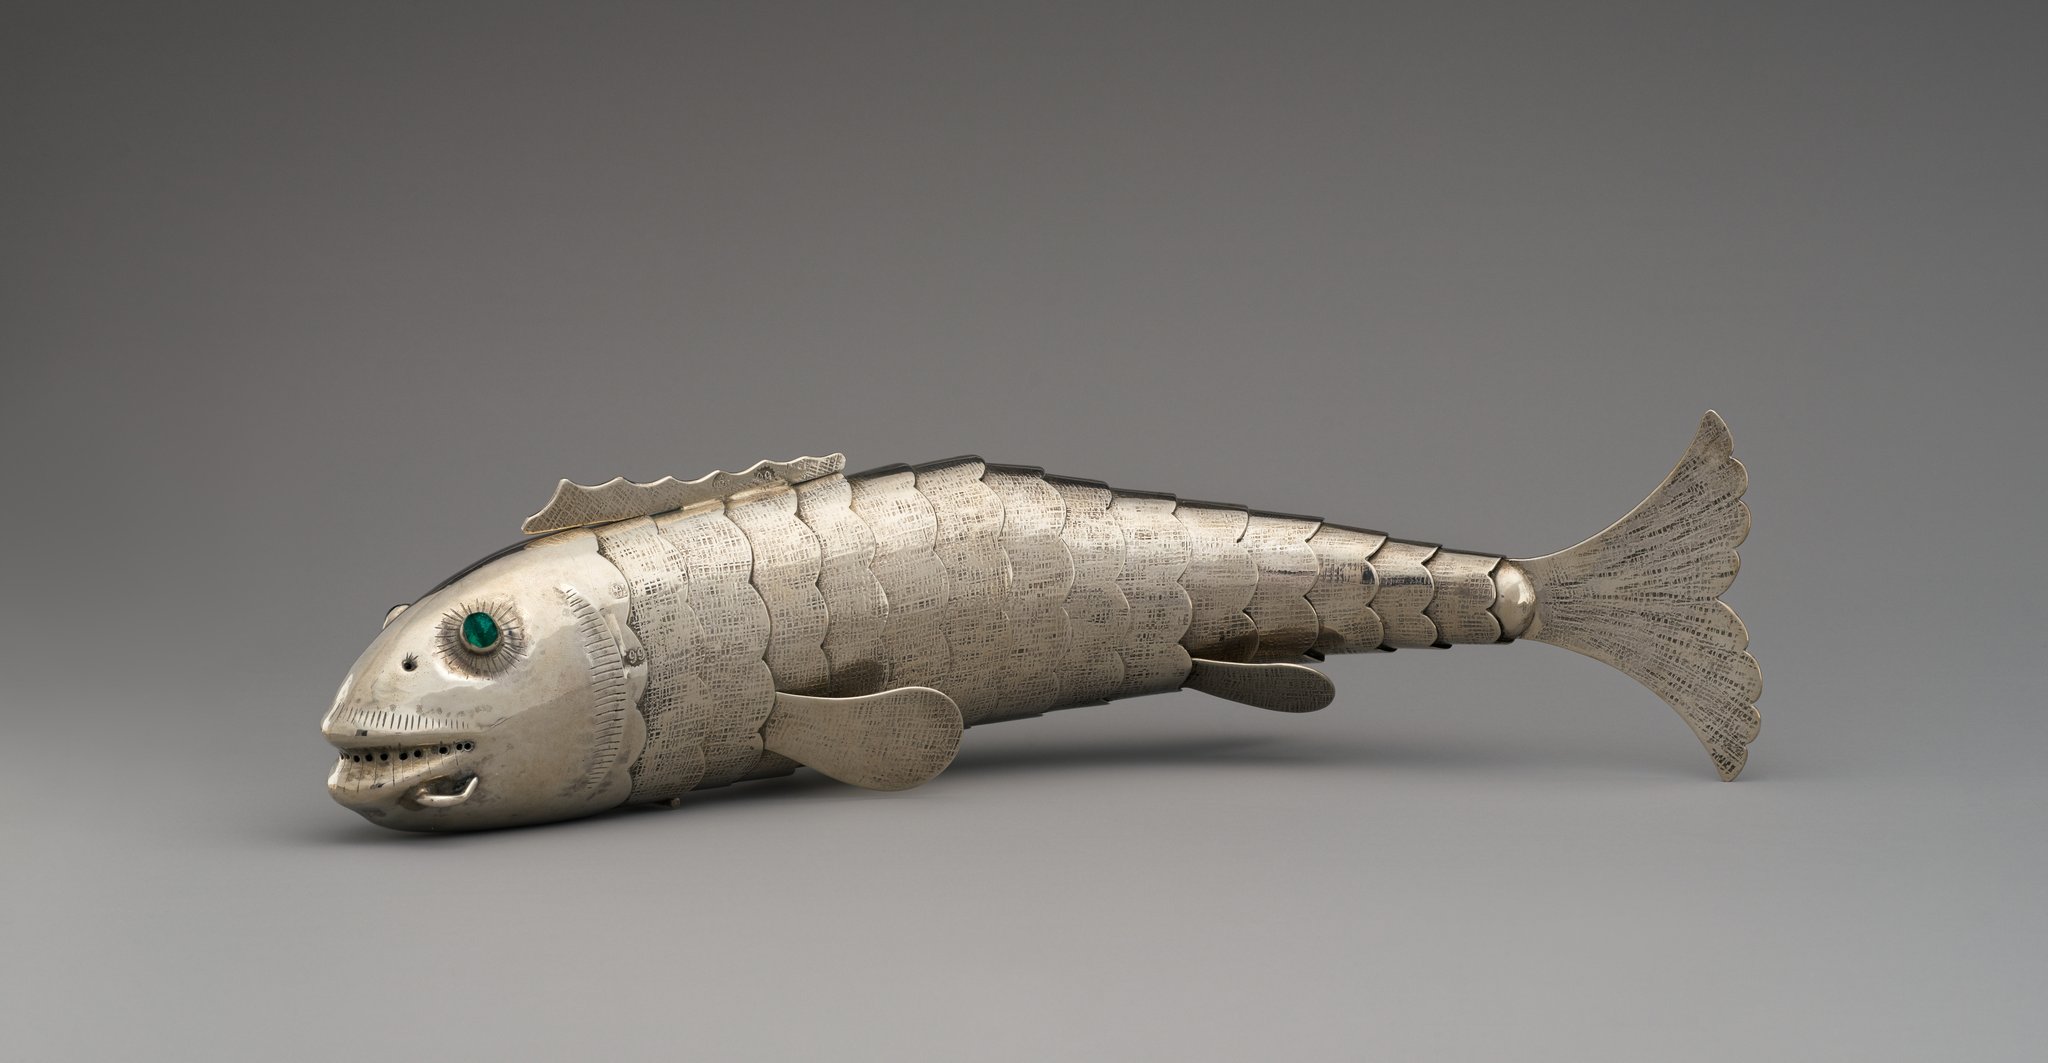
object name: spice container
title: Fish-form spice container (Besamim)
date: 1813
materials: foil, glass, silver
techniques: backing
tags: fish